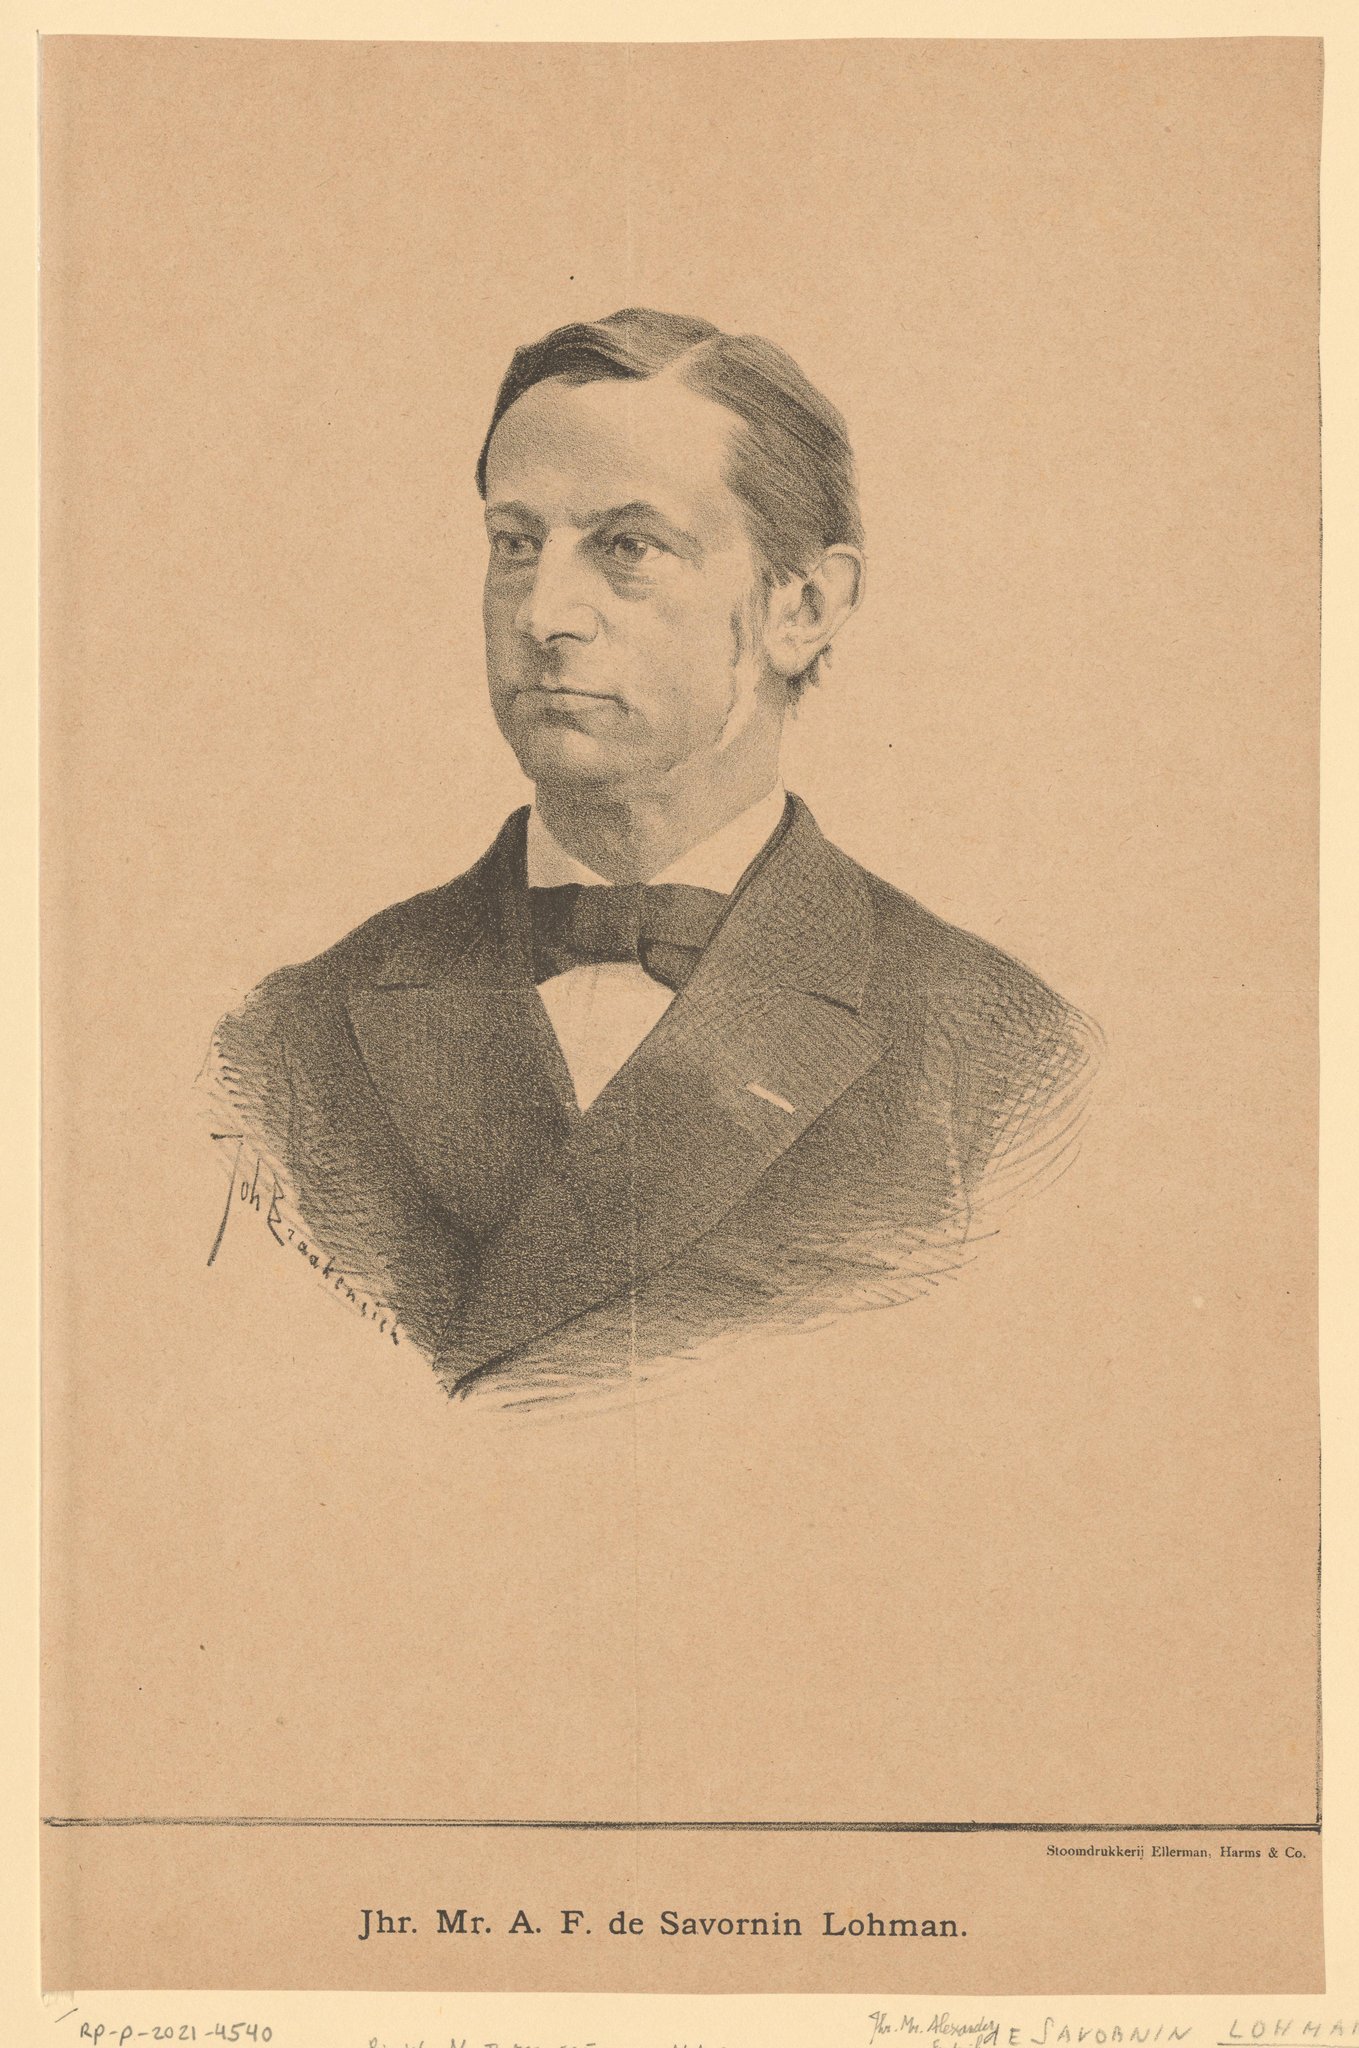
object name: print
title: Portret van Alexander de Savornin Lohman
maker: johan braakensiek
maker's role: draughtsman, print maker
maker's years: 1858-1940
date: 1889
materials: paper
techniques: lithograph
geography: netherlands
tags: jonkheer alexander frederik de savornin lohman, historical persons, politician, e.g. party leader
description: Prent uit het bijvoegsel van: De Amsterdammer. Weekblad voor Nederland, 15 december 1889.